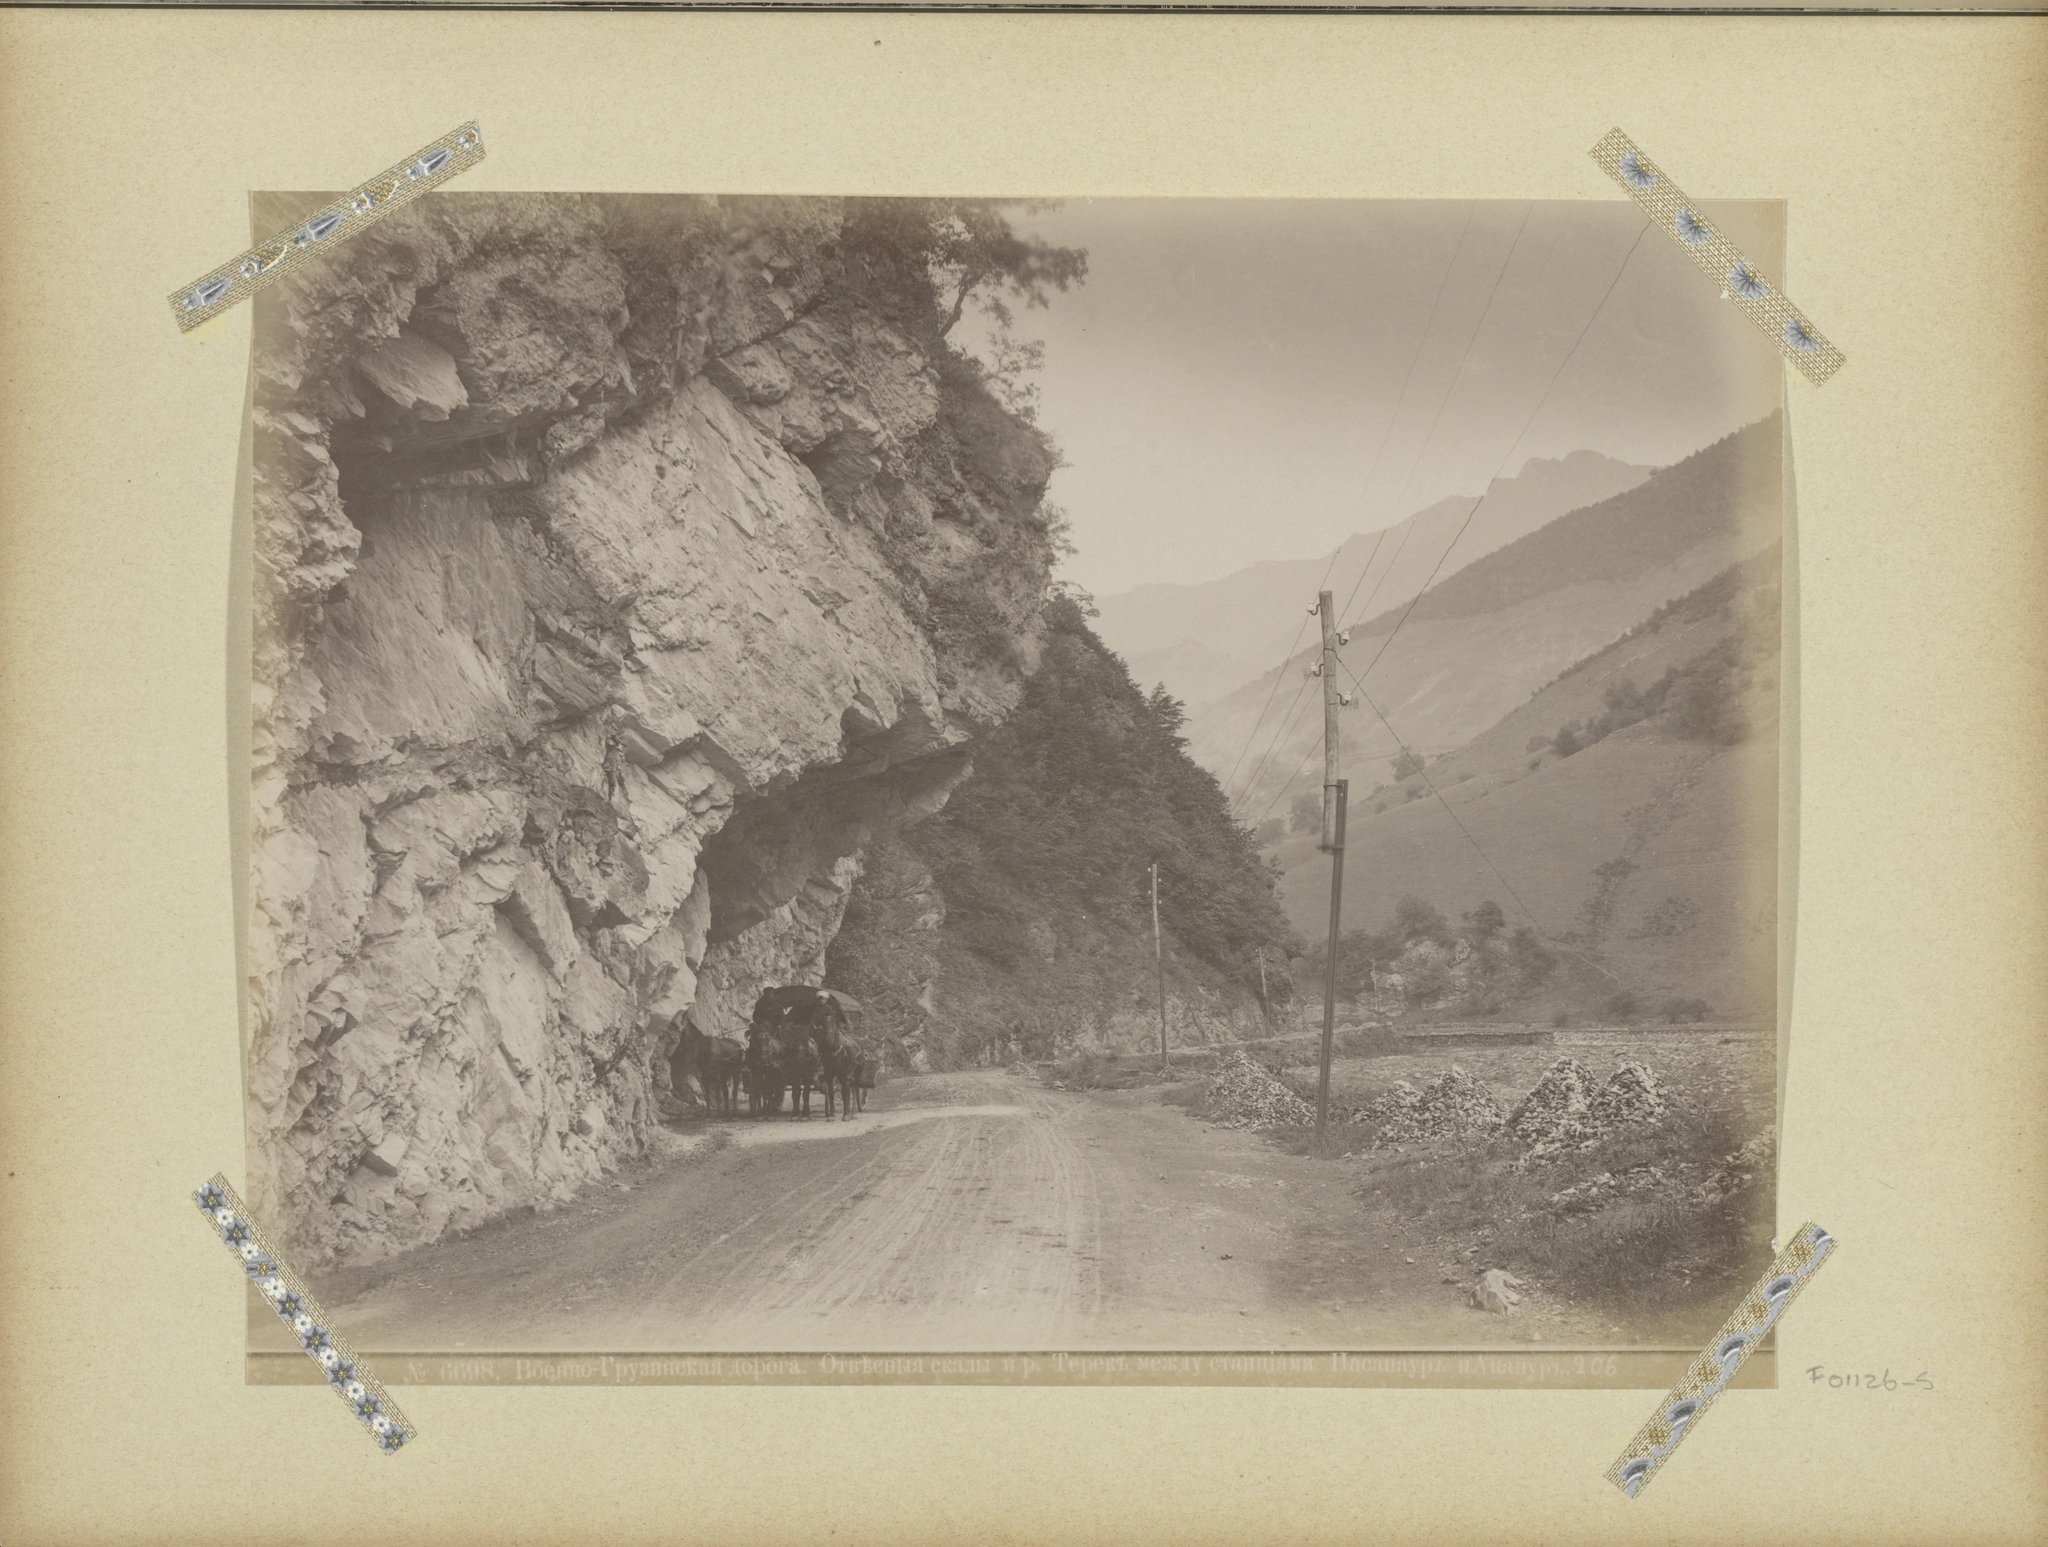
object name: photograph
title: Woenno-Groezinskaja doroga. Otwsija skali i r. Tjorjok mjochdoe stanijam Pasanaoer i Ananoer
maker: dimitri ivanovitch ermakov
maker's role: fotograaf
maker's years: 1845-1916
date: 1875-1890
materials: photographic support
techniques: albumen print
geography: georgia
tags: four-wheeled, animal-drawn vehicle, e.g.: cab, carriage, coach, road, path, rock-formations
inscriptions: number: ‘6698’, number: ‘206’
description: Onderdeel van Fotoalbum met opnames van bezienswaardigheden in Georgië, Sint-Petersburg en Moskou.